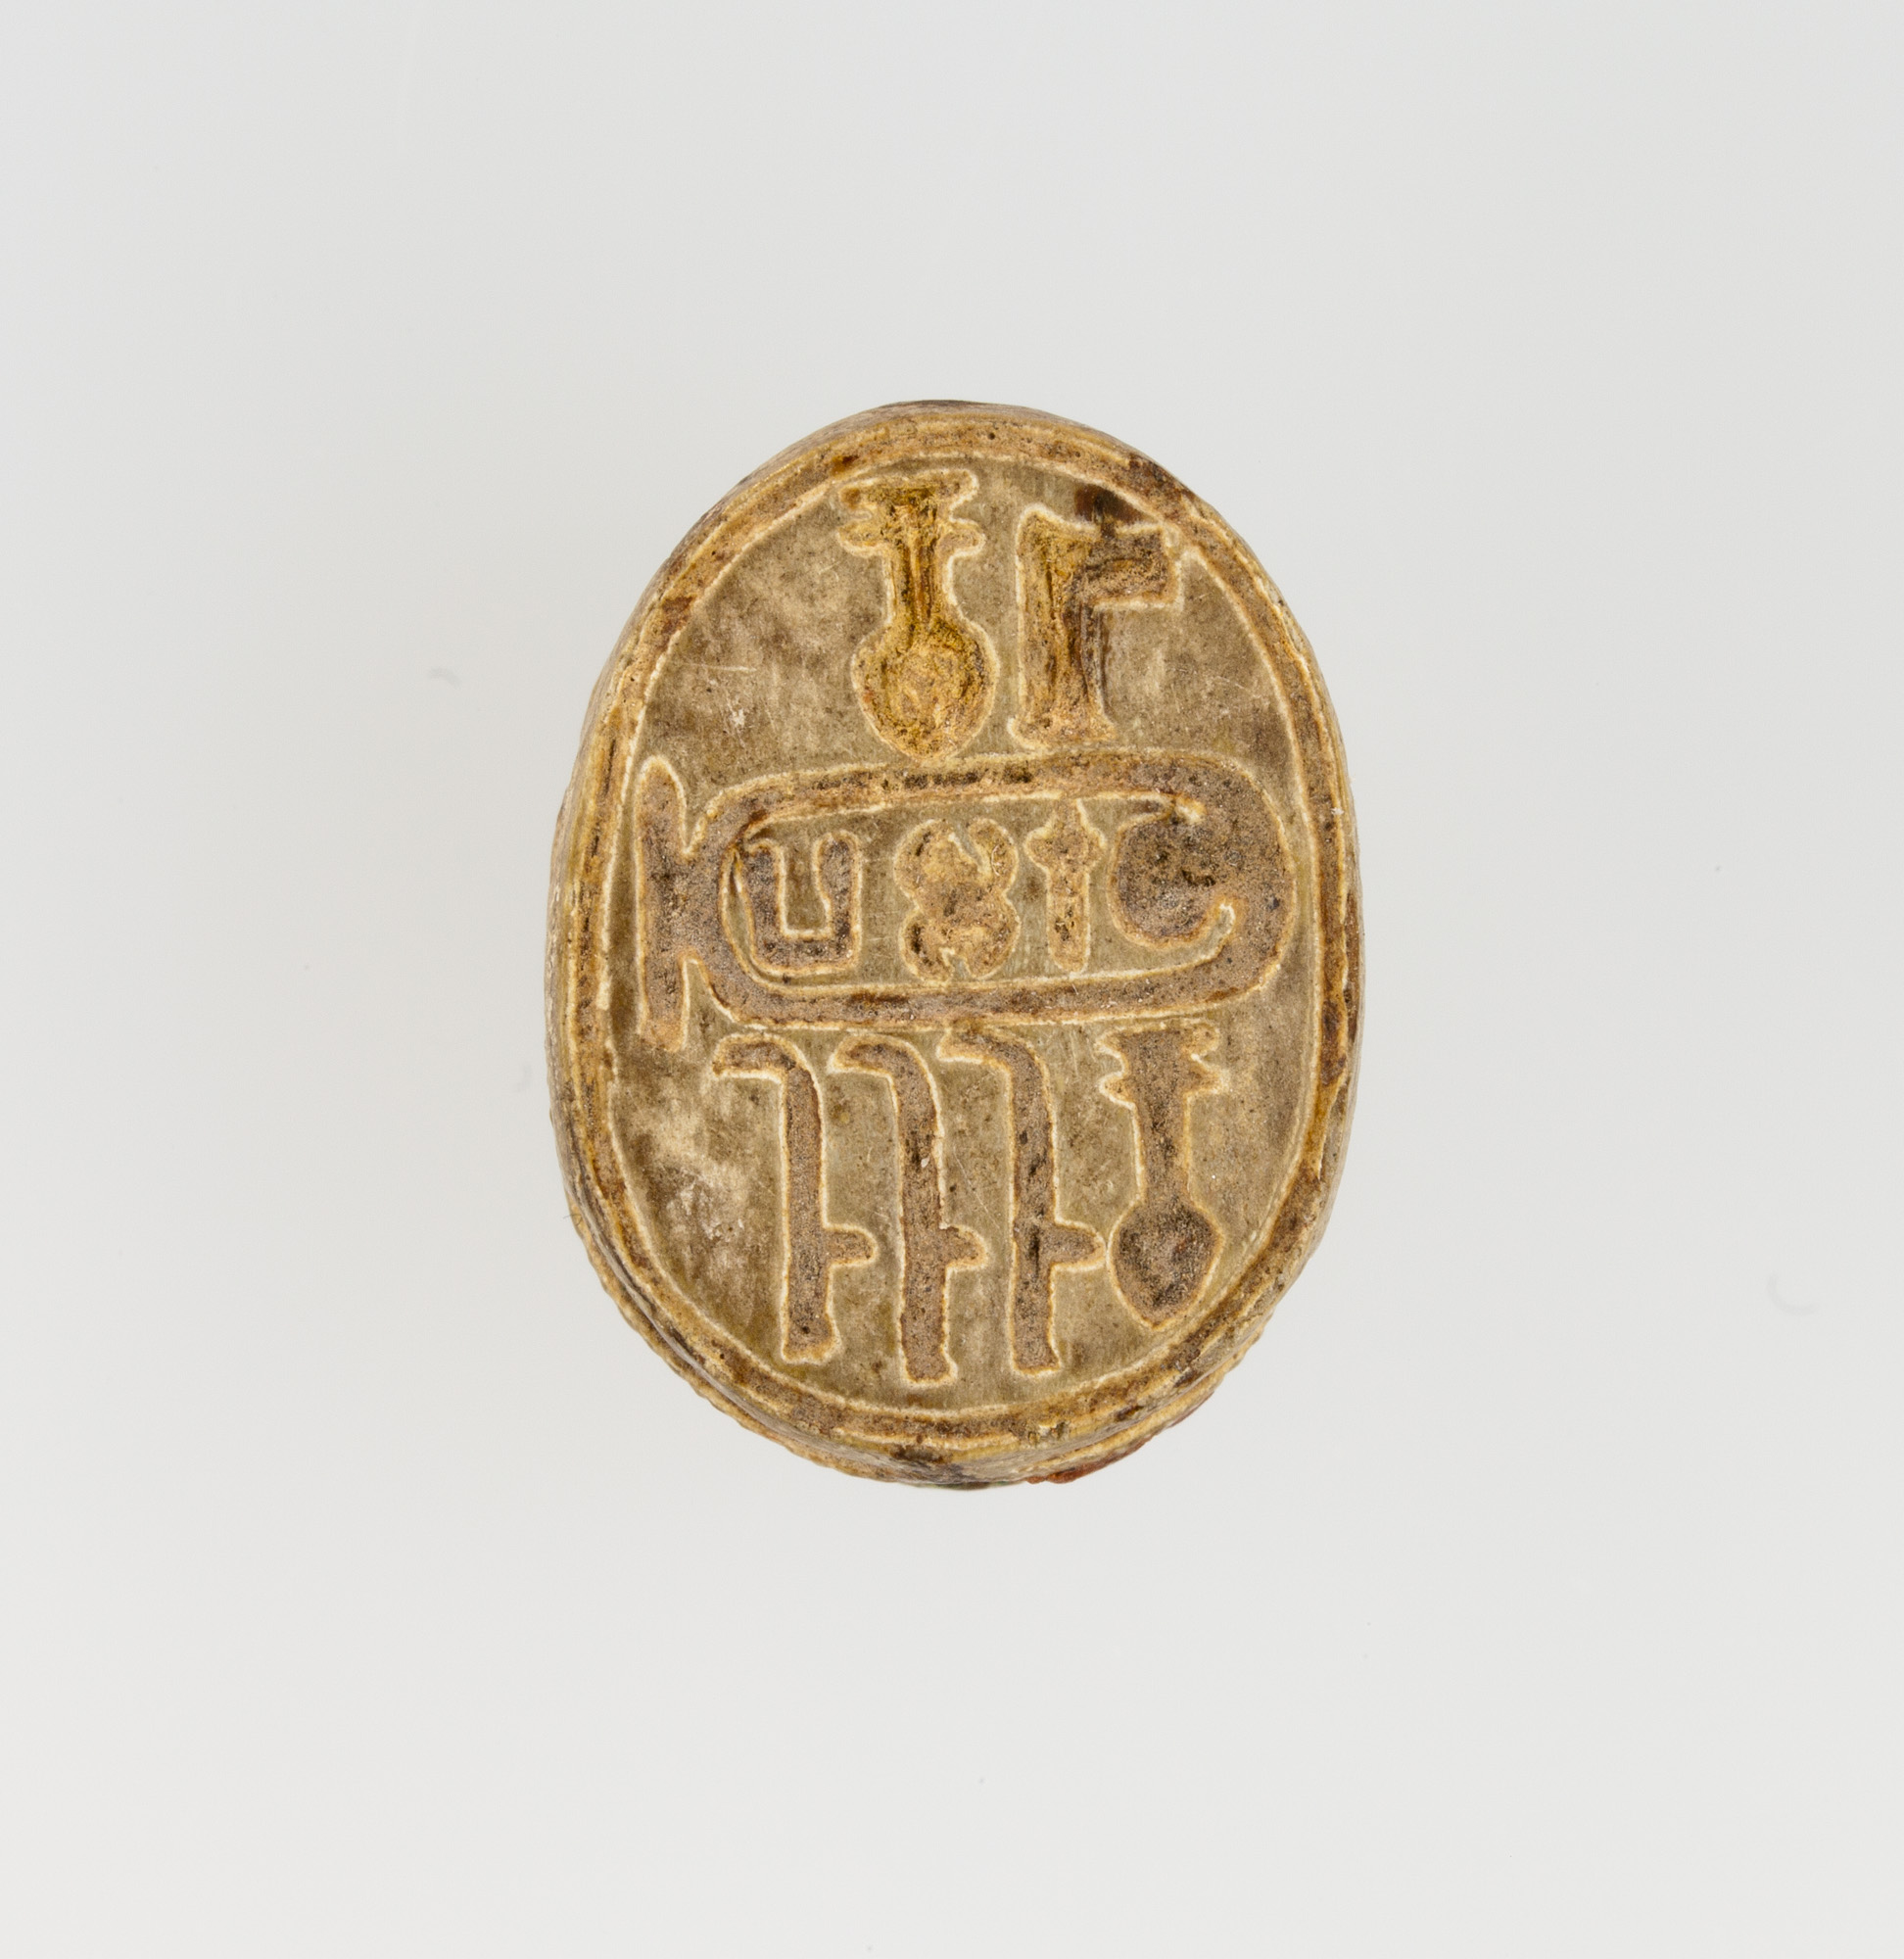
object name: scarab, thutmose i, aakheperkare, neferrenput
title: Scarab Inscribed with the Throne Name of Thutmose I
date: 1504-1492 BCE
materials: faience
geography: egypt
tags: hieroglyphs,scarabs